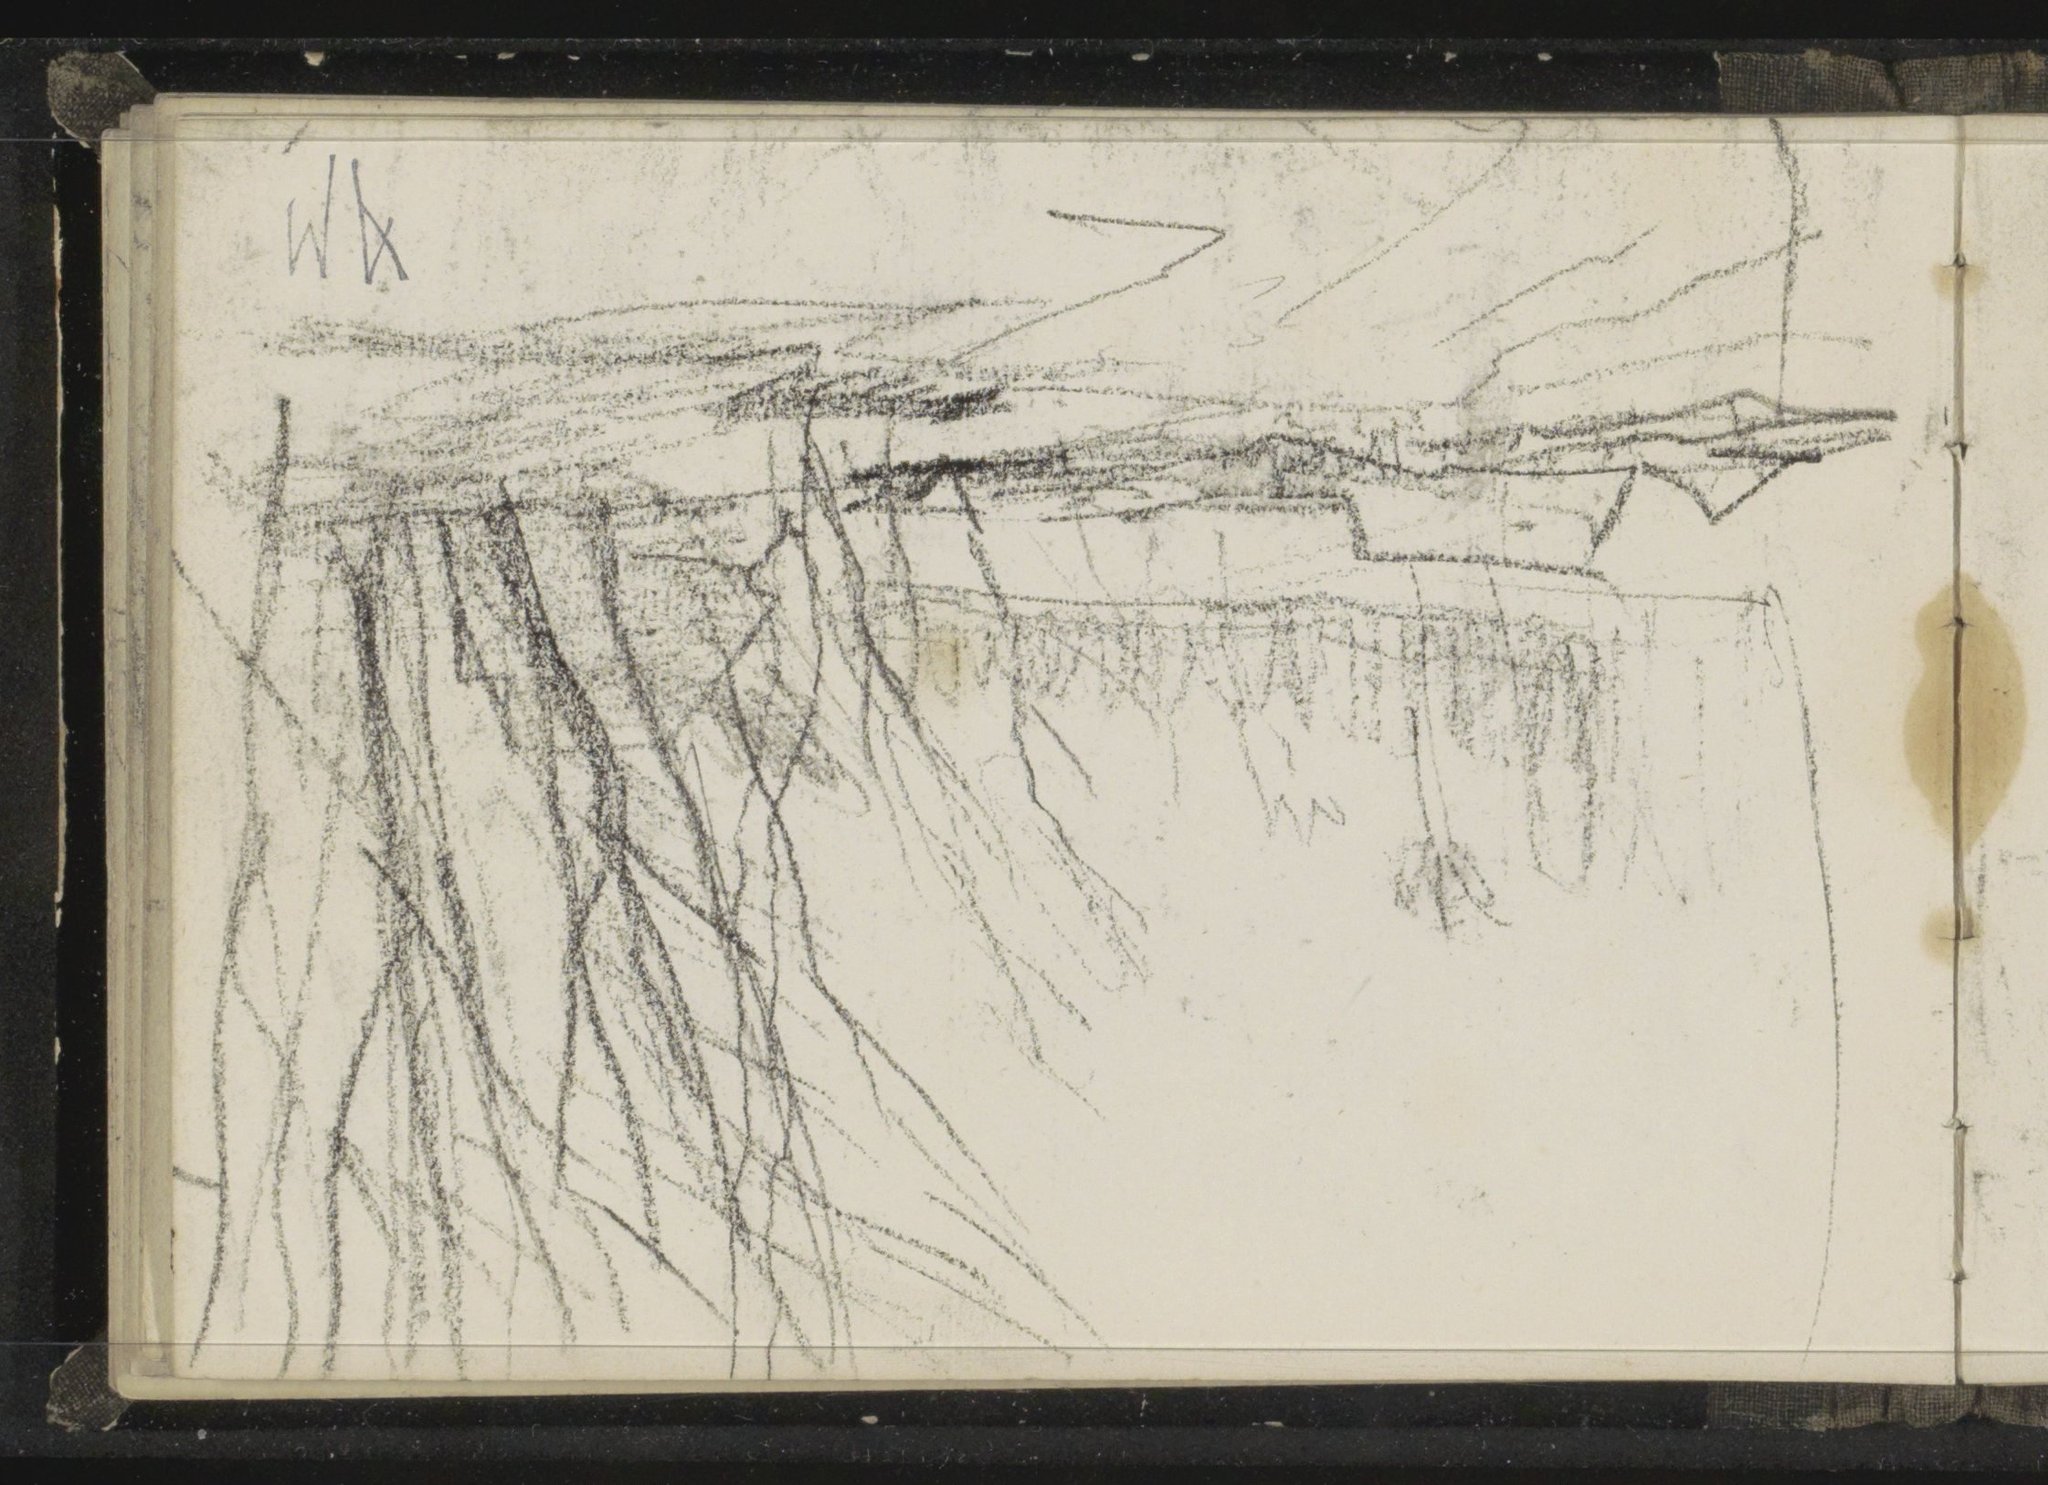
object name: sketchbook leaf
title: Landschap met bomen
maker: anton mauve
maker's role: draughtsman, painter, print maker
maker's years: 1838-1888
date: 1848-1888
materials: chalk, paper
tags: trees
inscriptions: monogram: ‘AM’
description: Blad 27 verso uit een schetsboek met 33 bladen.